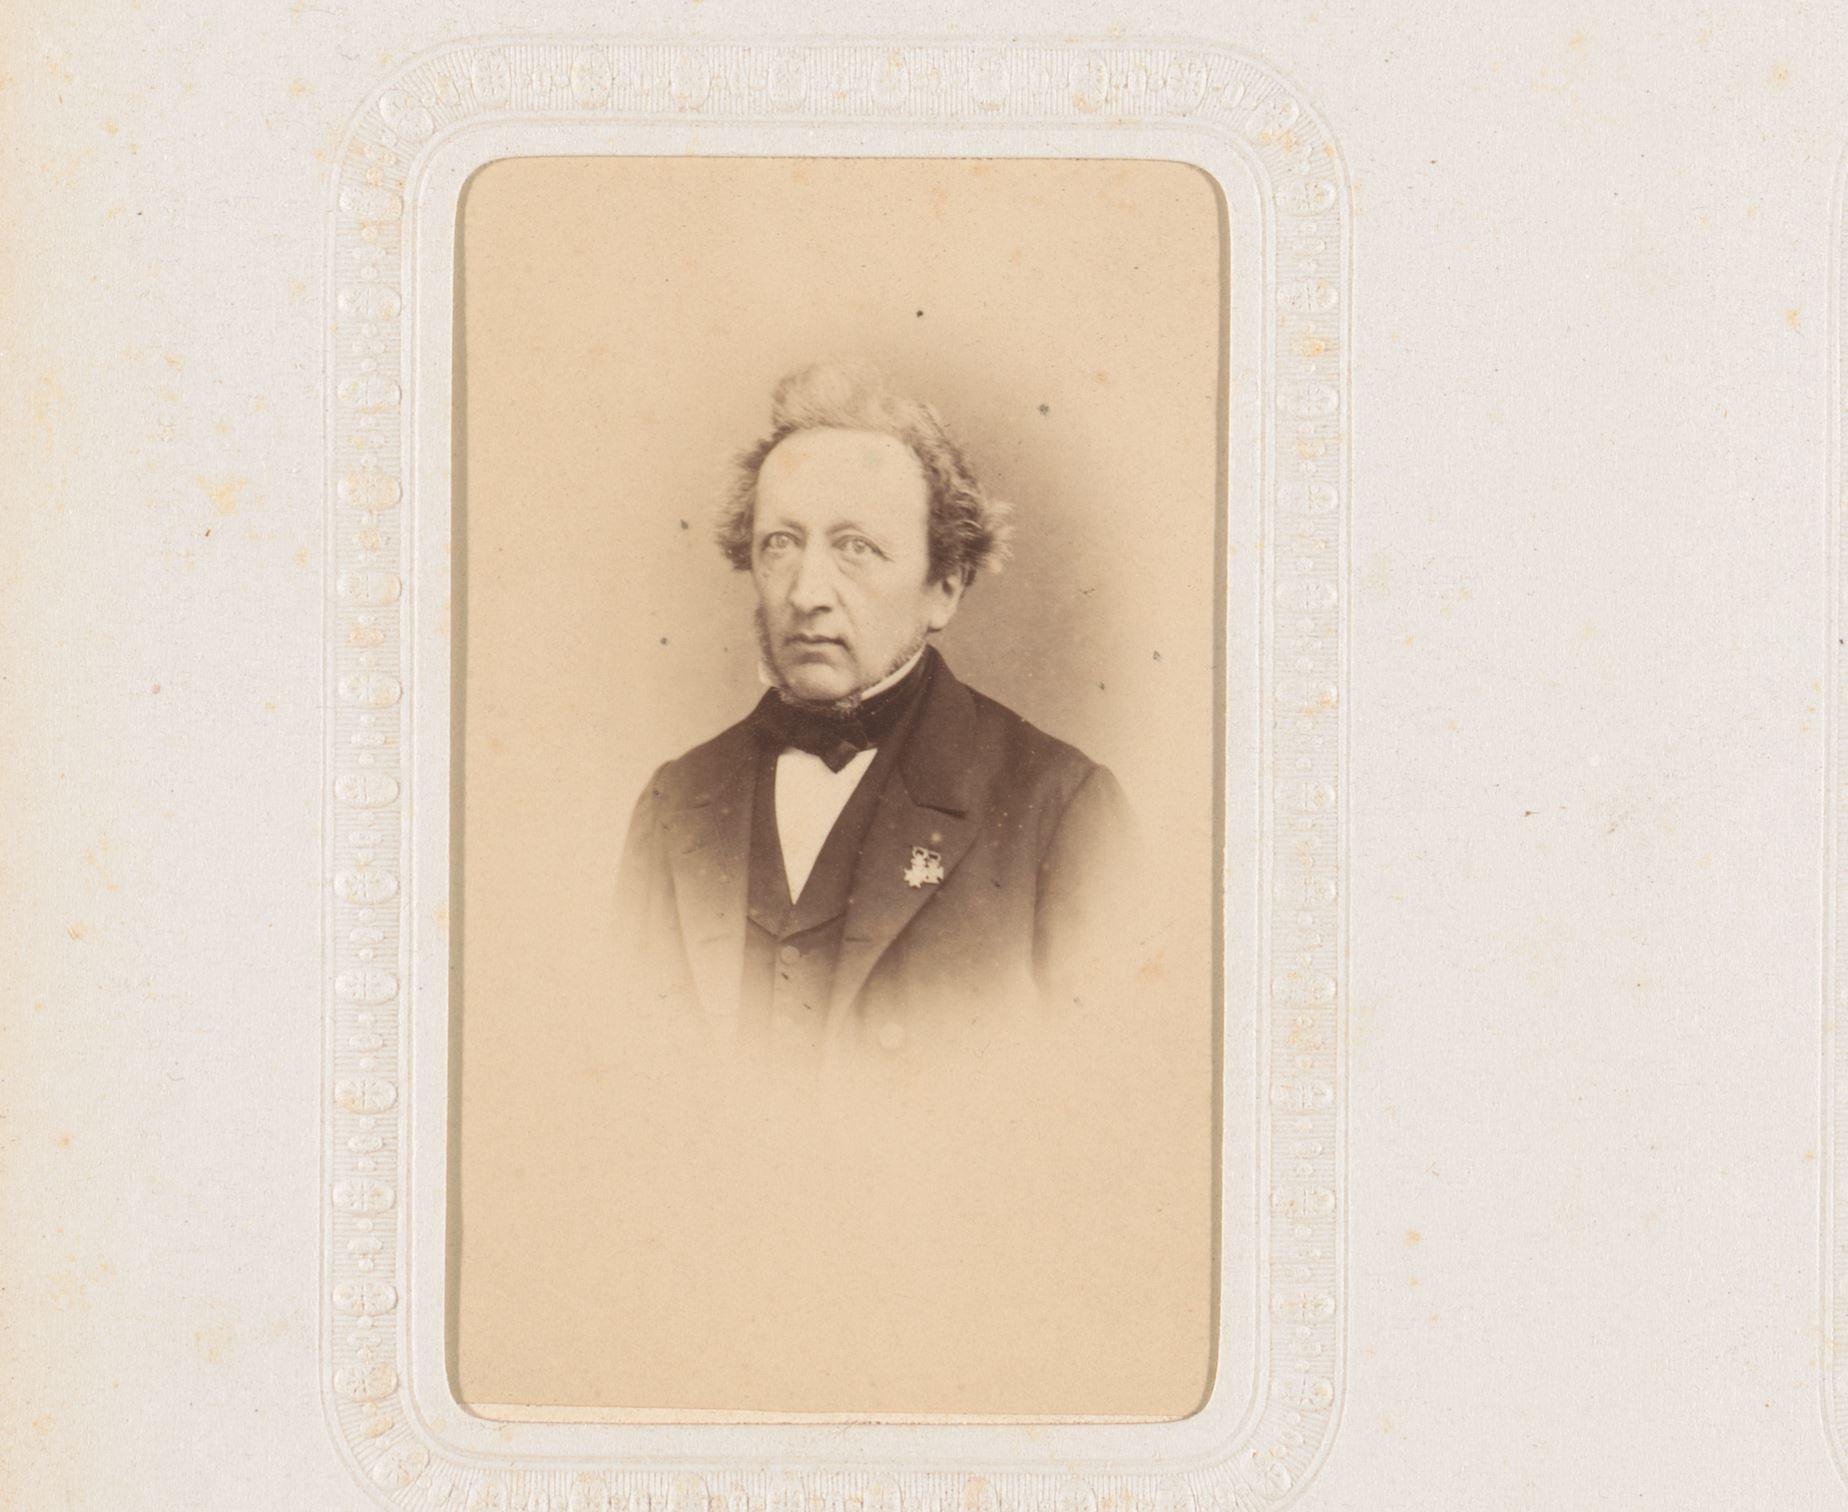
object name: photograph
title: Portret van een man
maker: Anonymous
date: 1850-1880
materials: cardboard, photographic support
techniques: albumen print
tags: adult man, historical persons